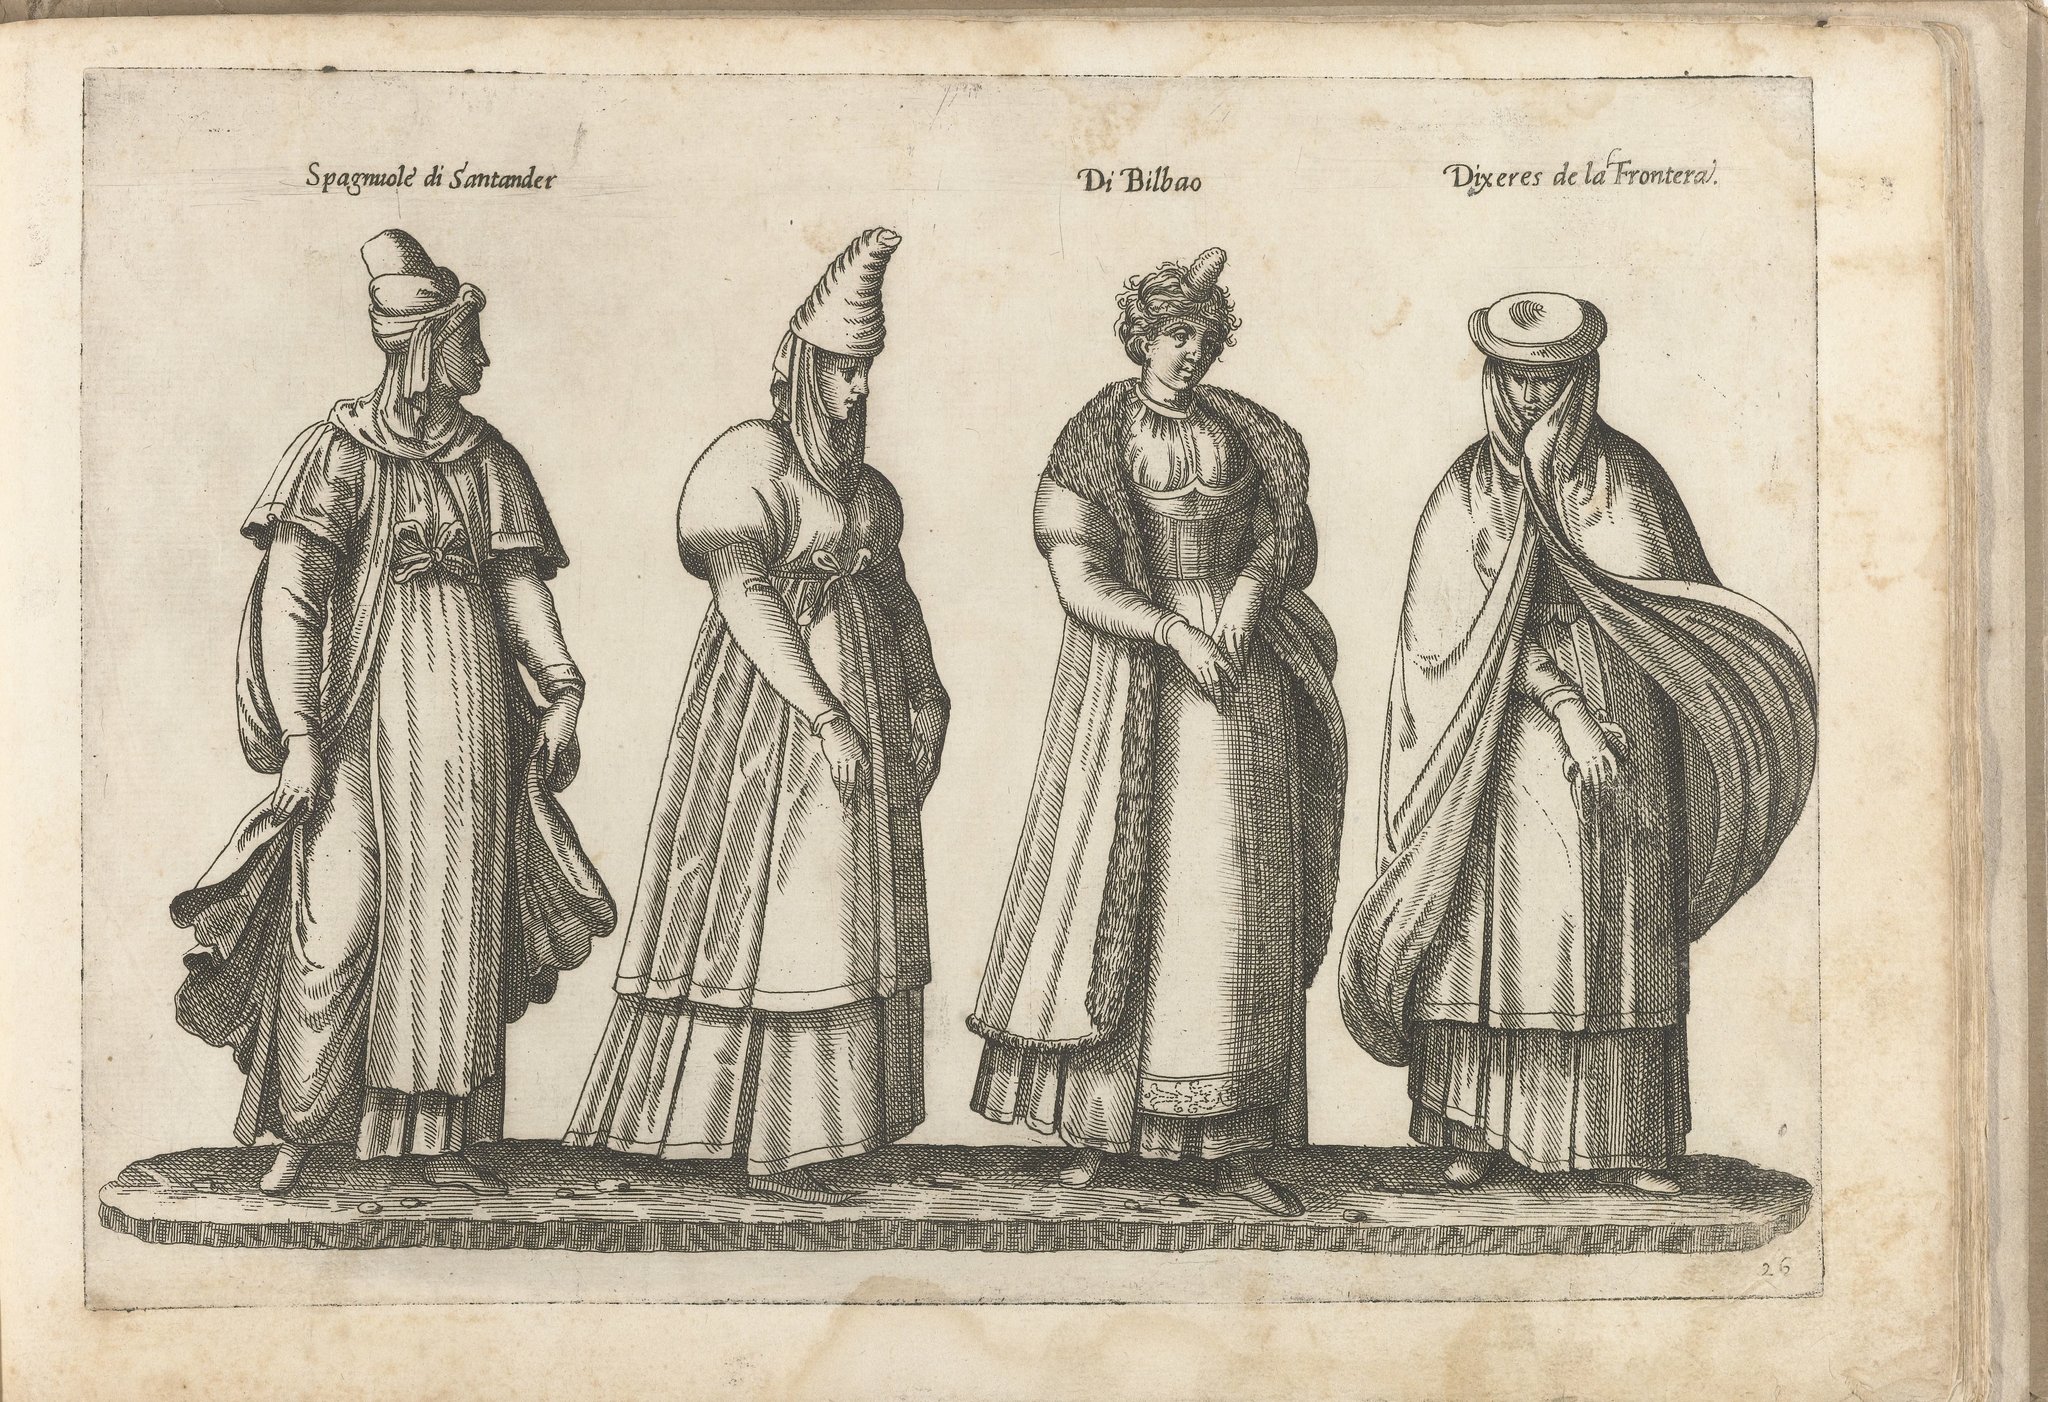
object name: costume print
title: Spagnuole di Santander / Di Bilbao / Dixeres de la Frontera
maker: bartolomeo grassi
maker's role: publisher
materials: paper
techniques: engraving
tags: europeans: spaniards (+ costume)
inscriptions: number: ‘25’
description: Prent nr. 26 uit album 'Dei veri ritratti degl'habiti di tvtte le parti del mondo intagliati in rame per opra di Bartolomeo Grassi', 1585.